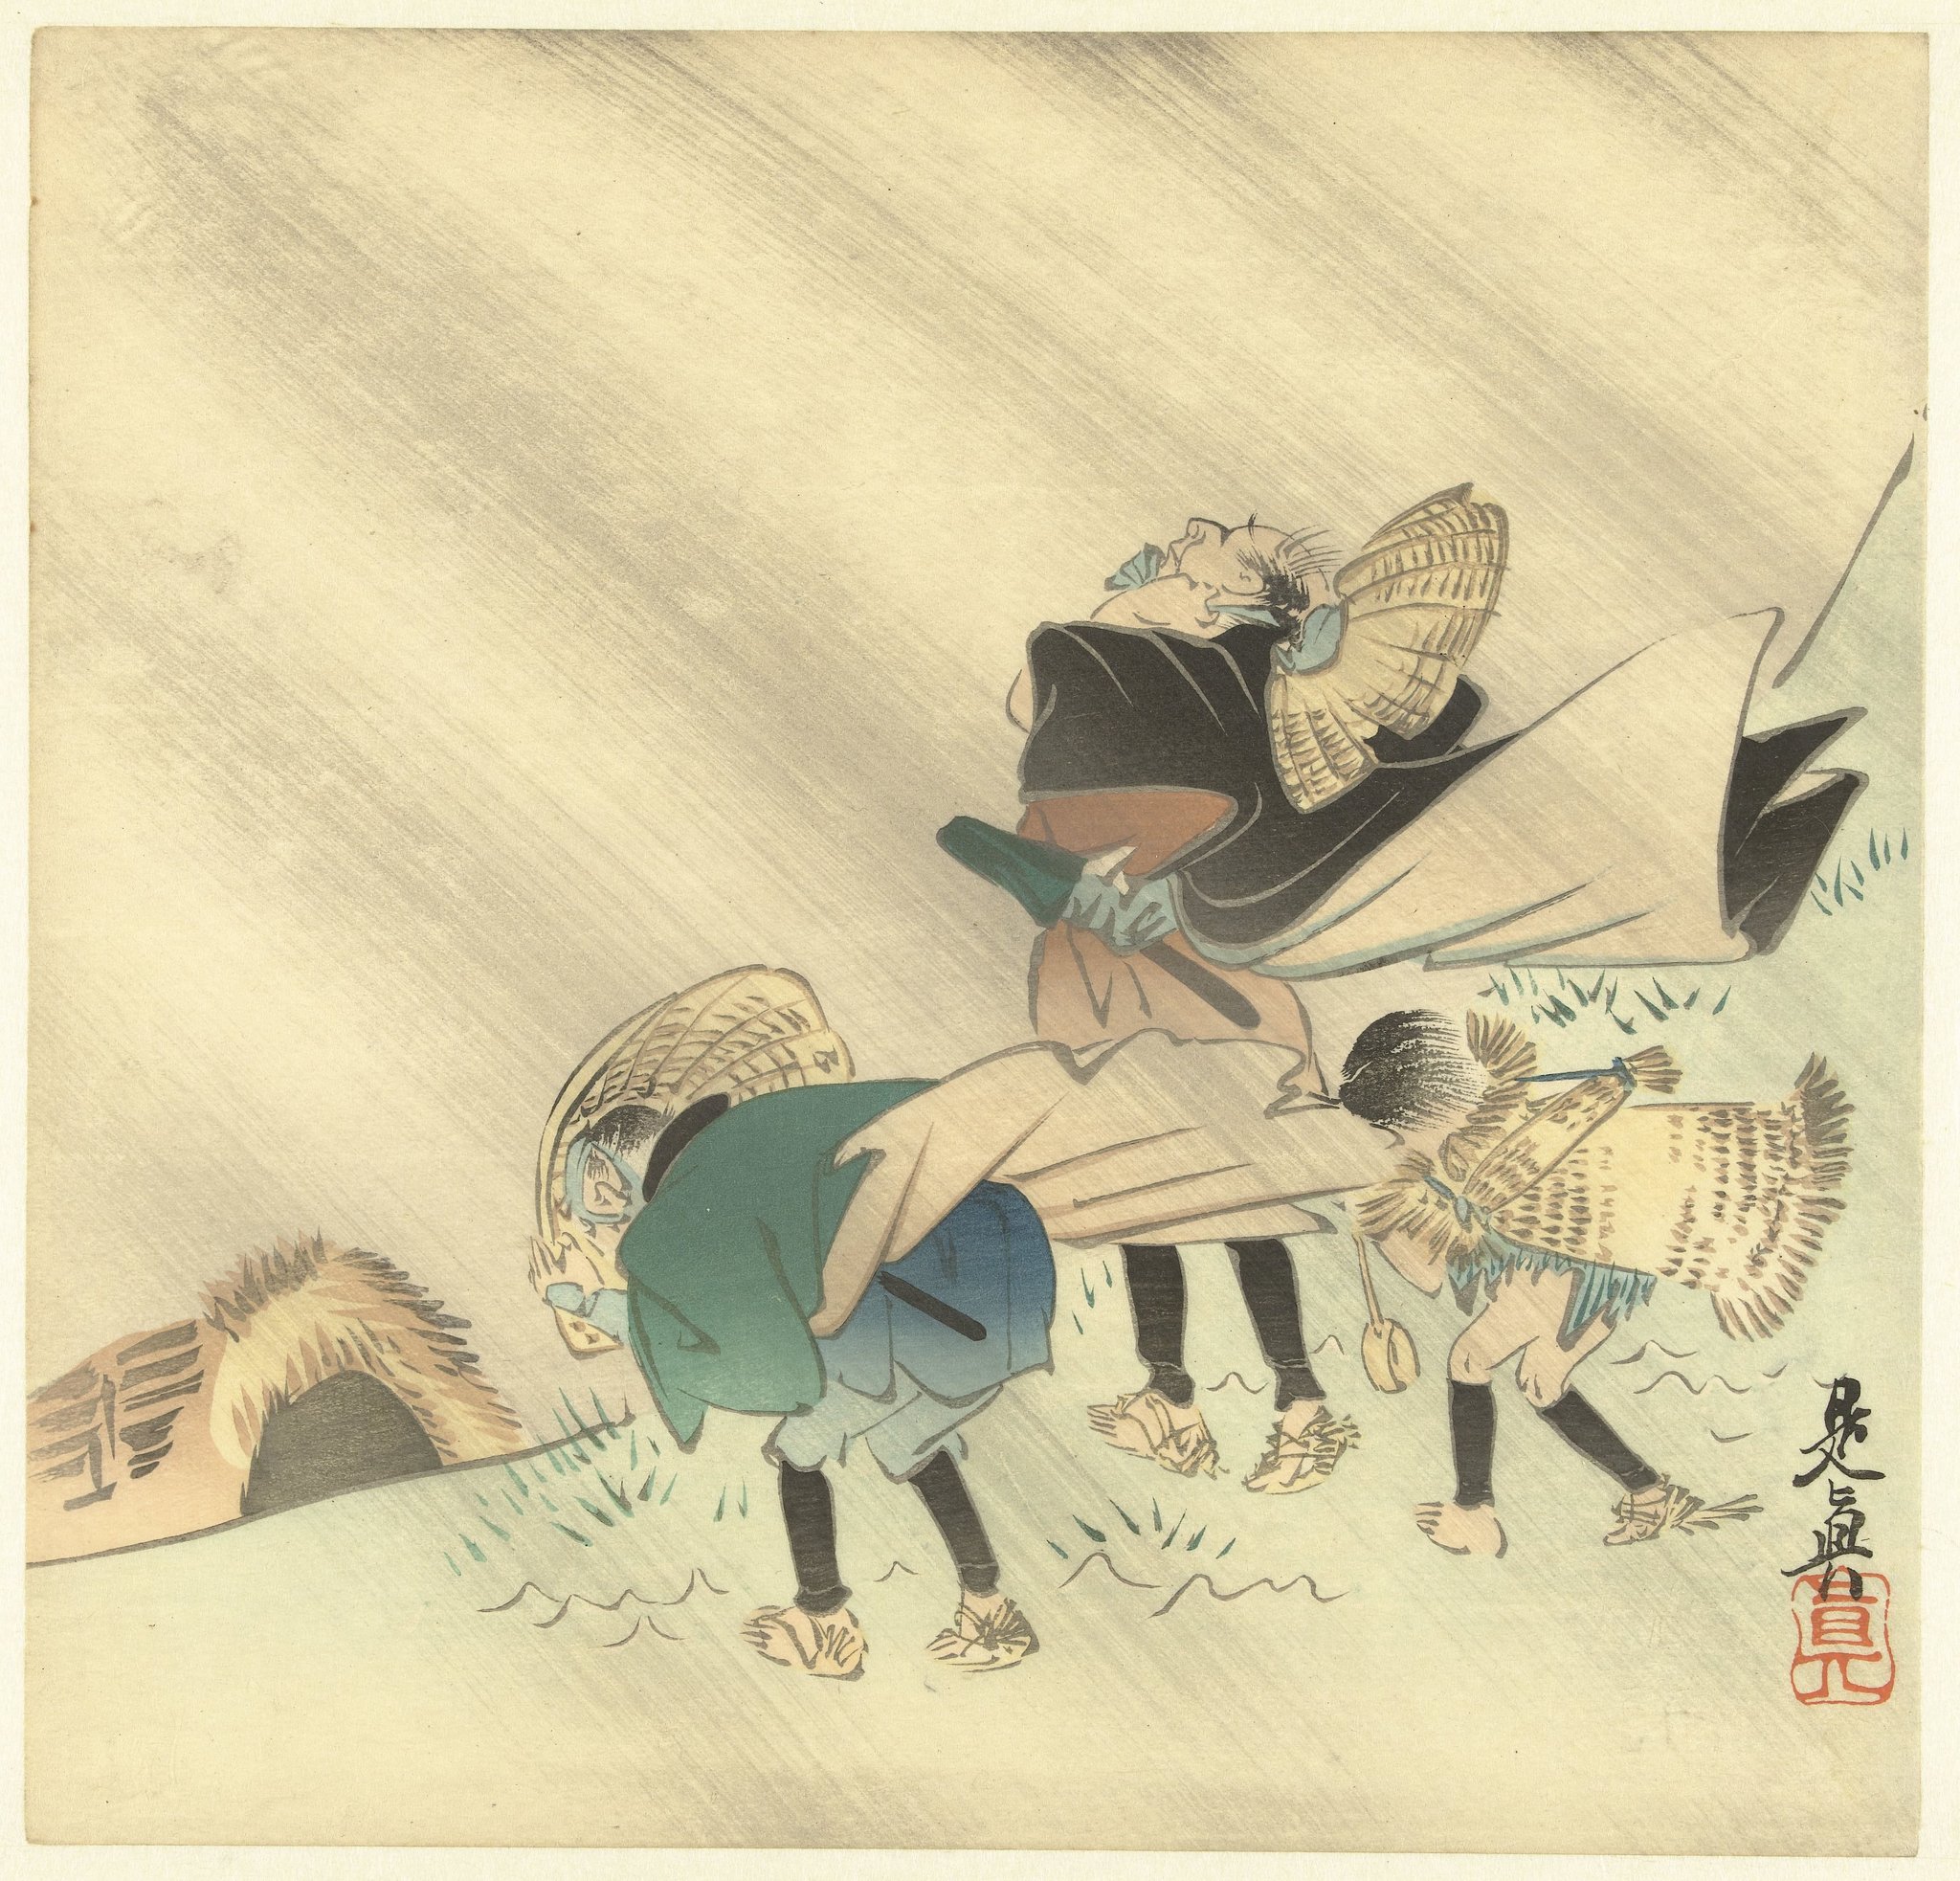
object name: print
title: Reizigers in een storm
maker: shibata zeshin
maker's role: print maker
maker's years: 1807-1891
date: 1880-1890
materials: paper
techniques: woodcut, nishiki e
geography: japan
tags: rain, storm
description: Twee mannen en een jongetje in regen en harde wind hun hoeden en mantels vasthoudend; op de achtergrond een rieten hut.